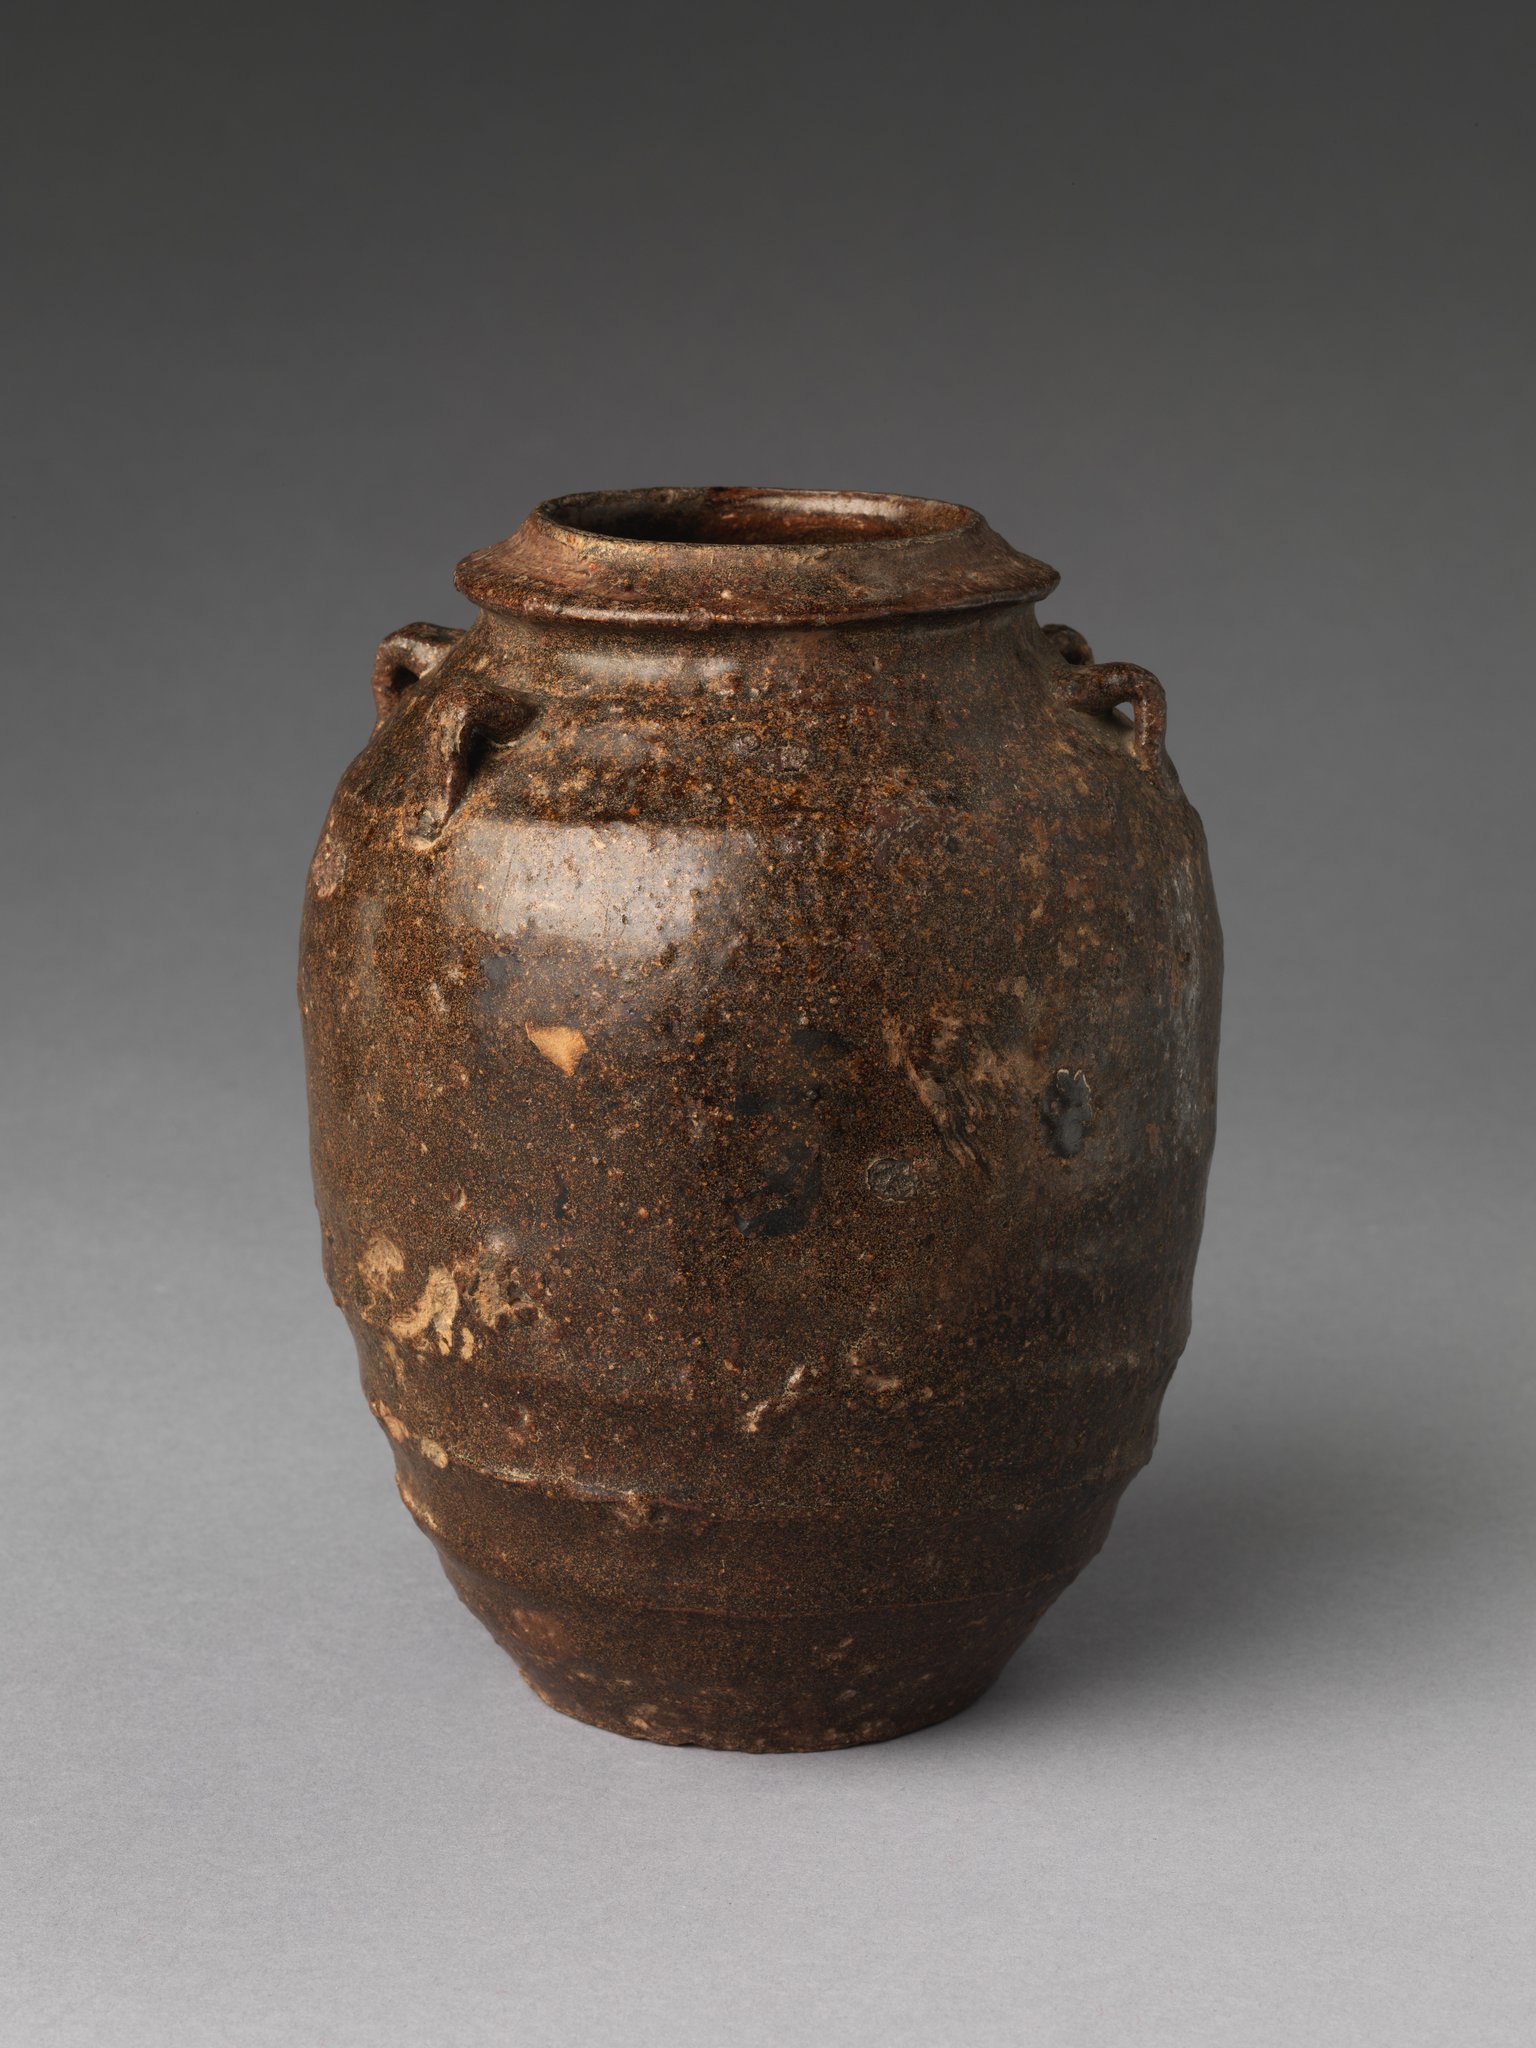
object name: jar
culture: japanese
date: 1701-1800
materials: clay, glaze